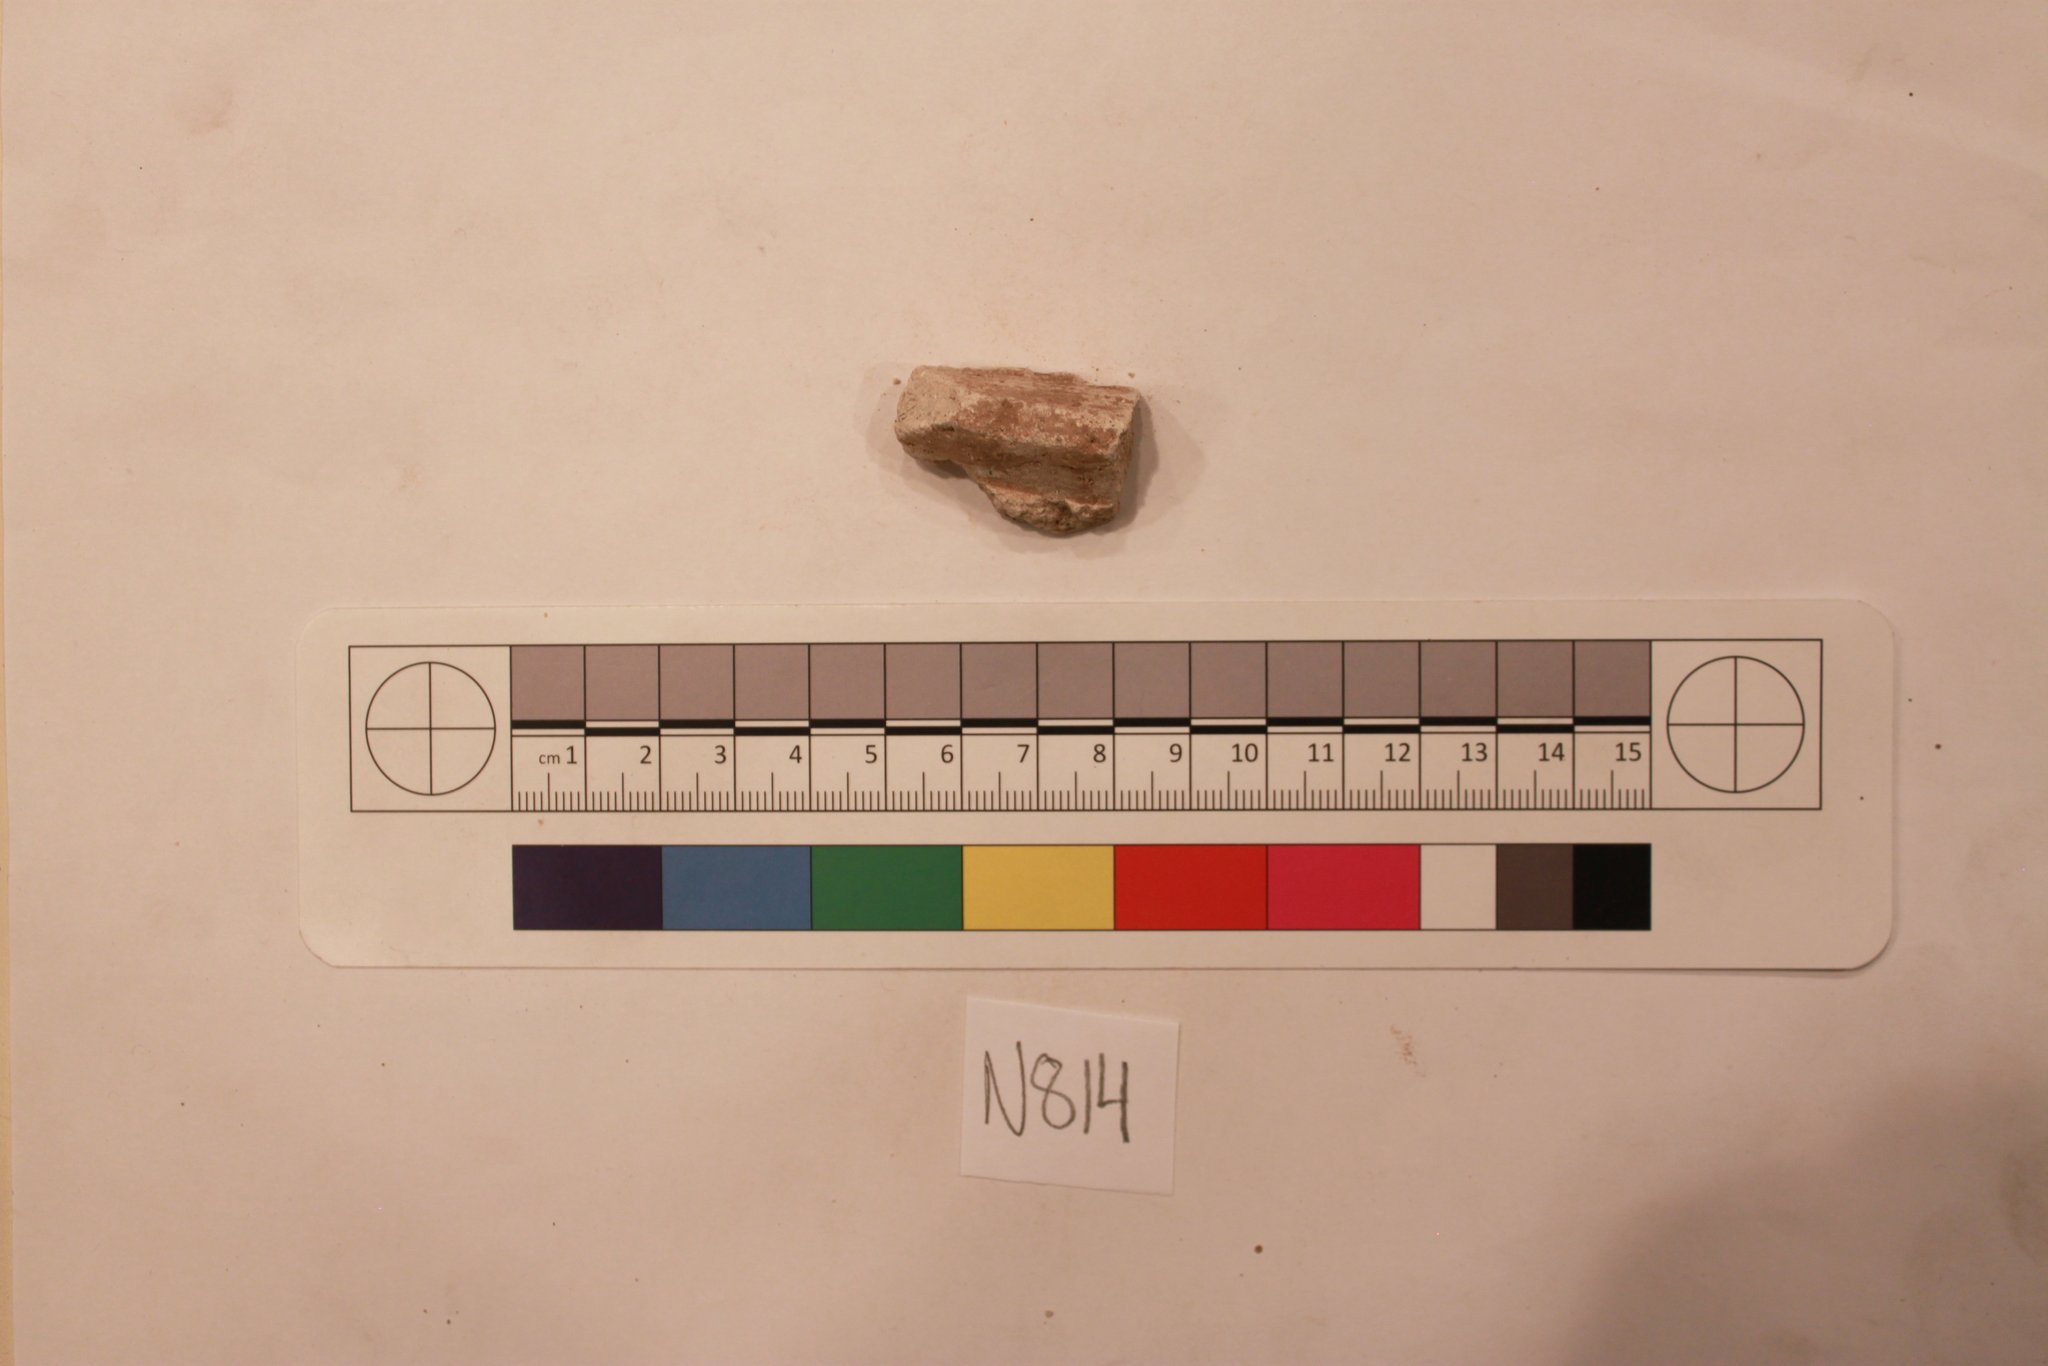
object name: fragment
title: Stucco Fragment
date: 701-1200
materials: plaster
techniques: carving, painting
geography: iran